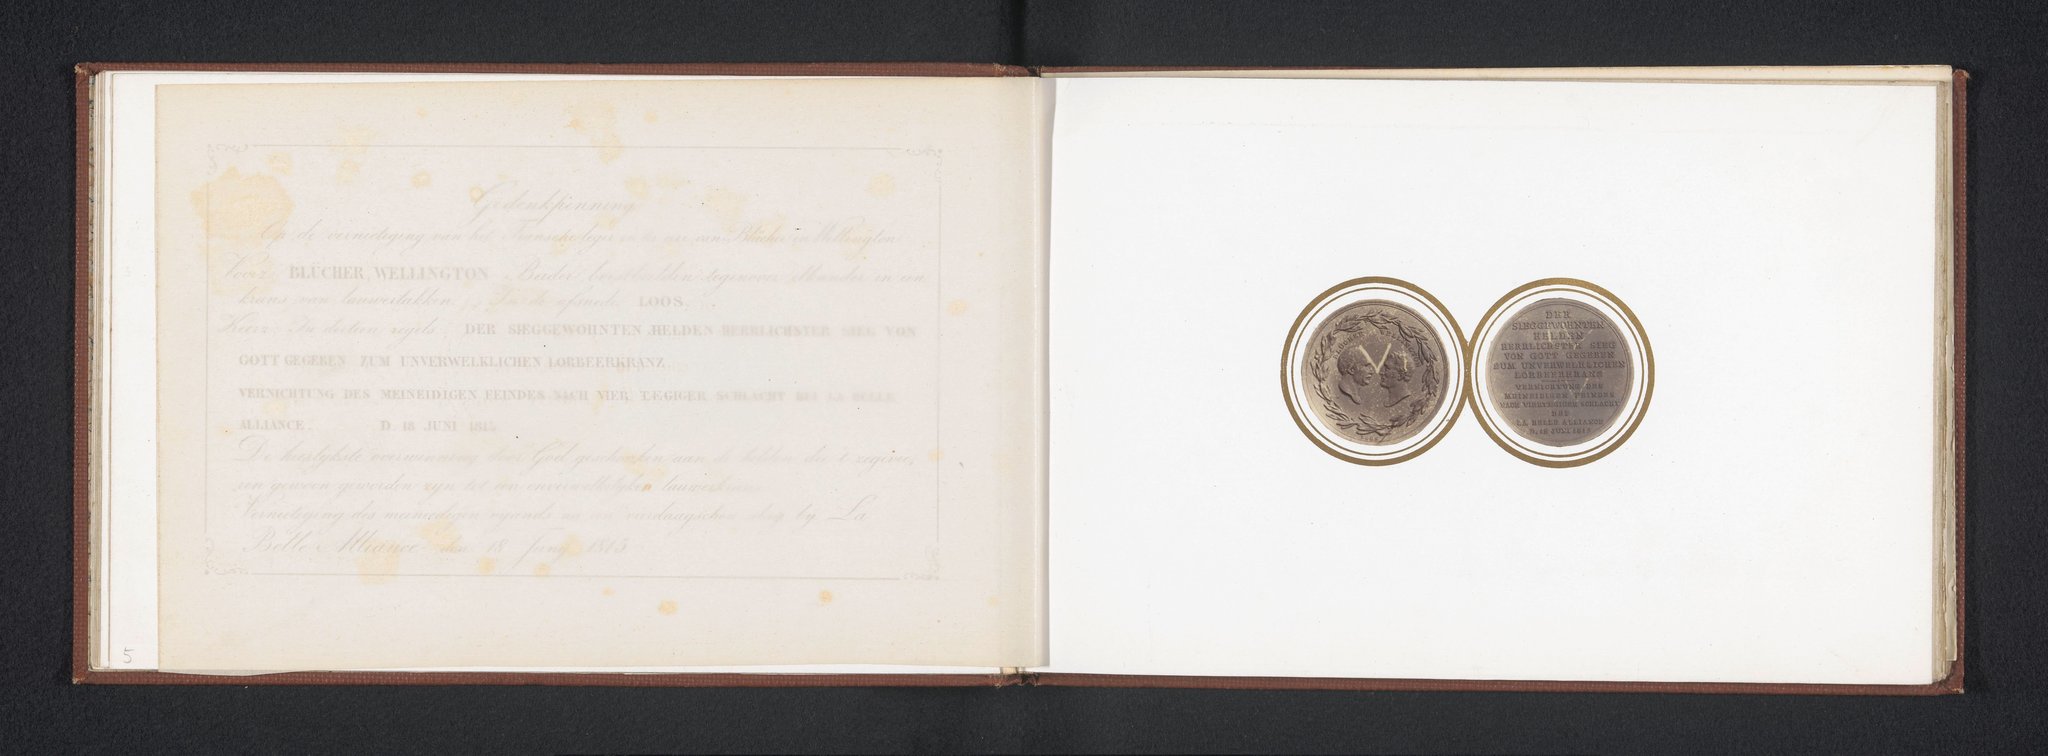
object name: page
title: Twee afbeeldingen van een gedenkpenning ter ere van de Duke of Wellington en Gebhard von Blücher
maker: willem matla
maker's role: fotograaf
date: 1865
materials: paper, photographic support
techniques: albumen print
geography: the hague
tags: memorial medal, adult man (+ sideview, profile)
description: Links de voorzijde met twee bustes van de Duke of Wellington en Gebhard von Blücher, rechts de keerzijde met een gedenktekst.